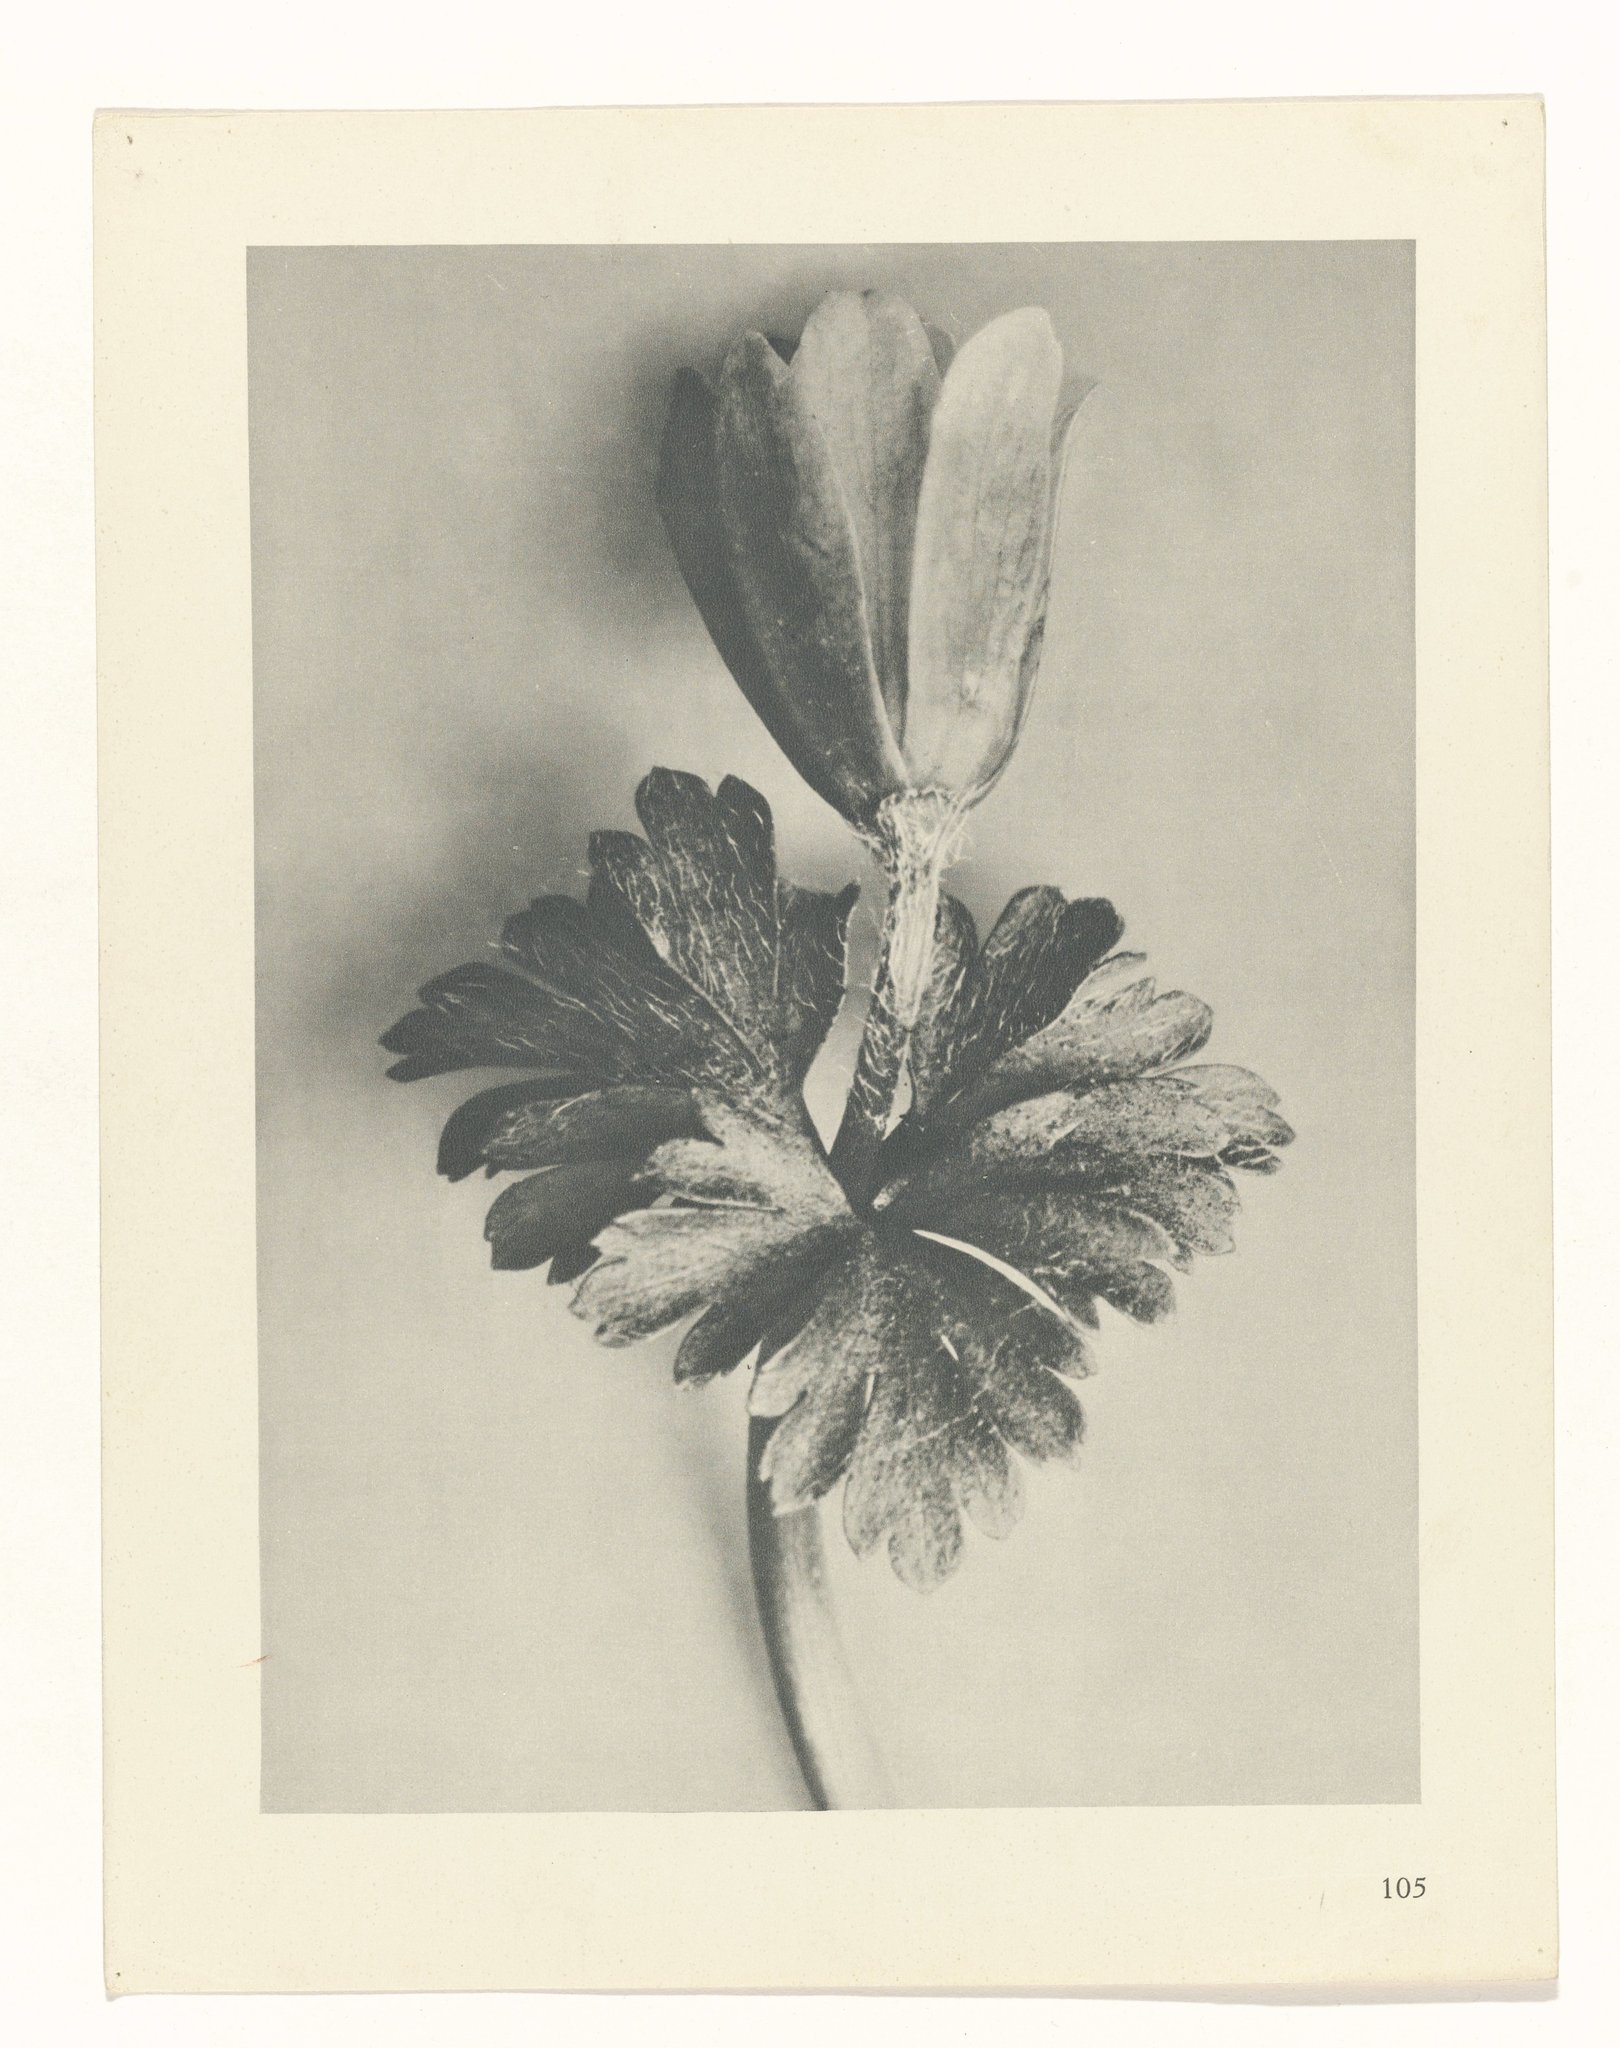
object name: photograph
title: Plantstudie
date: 1928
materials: ink, paper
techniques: rotogravure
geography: berlin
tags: plants (in general)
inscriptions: number: ‘105’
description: facher Vergrößerung. Afkomstig uit losbladige uitgave.